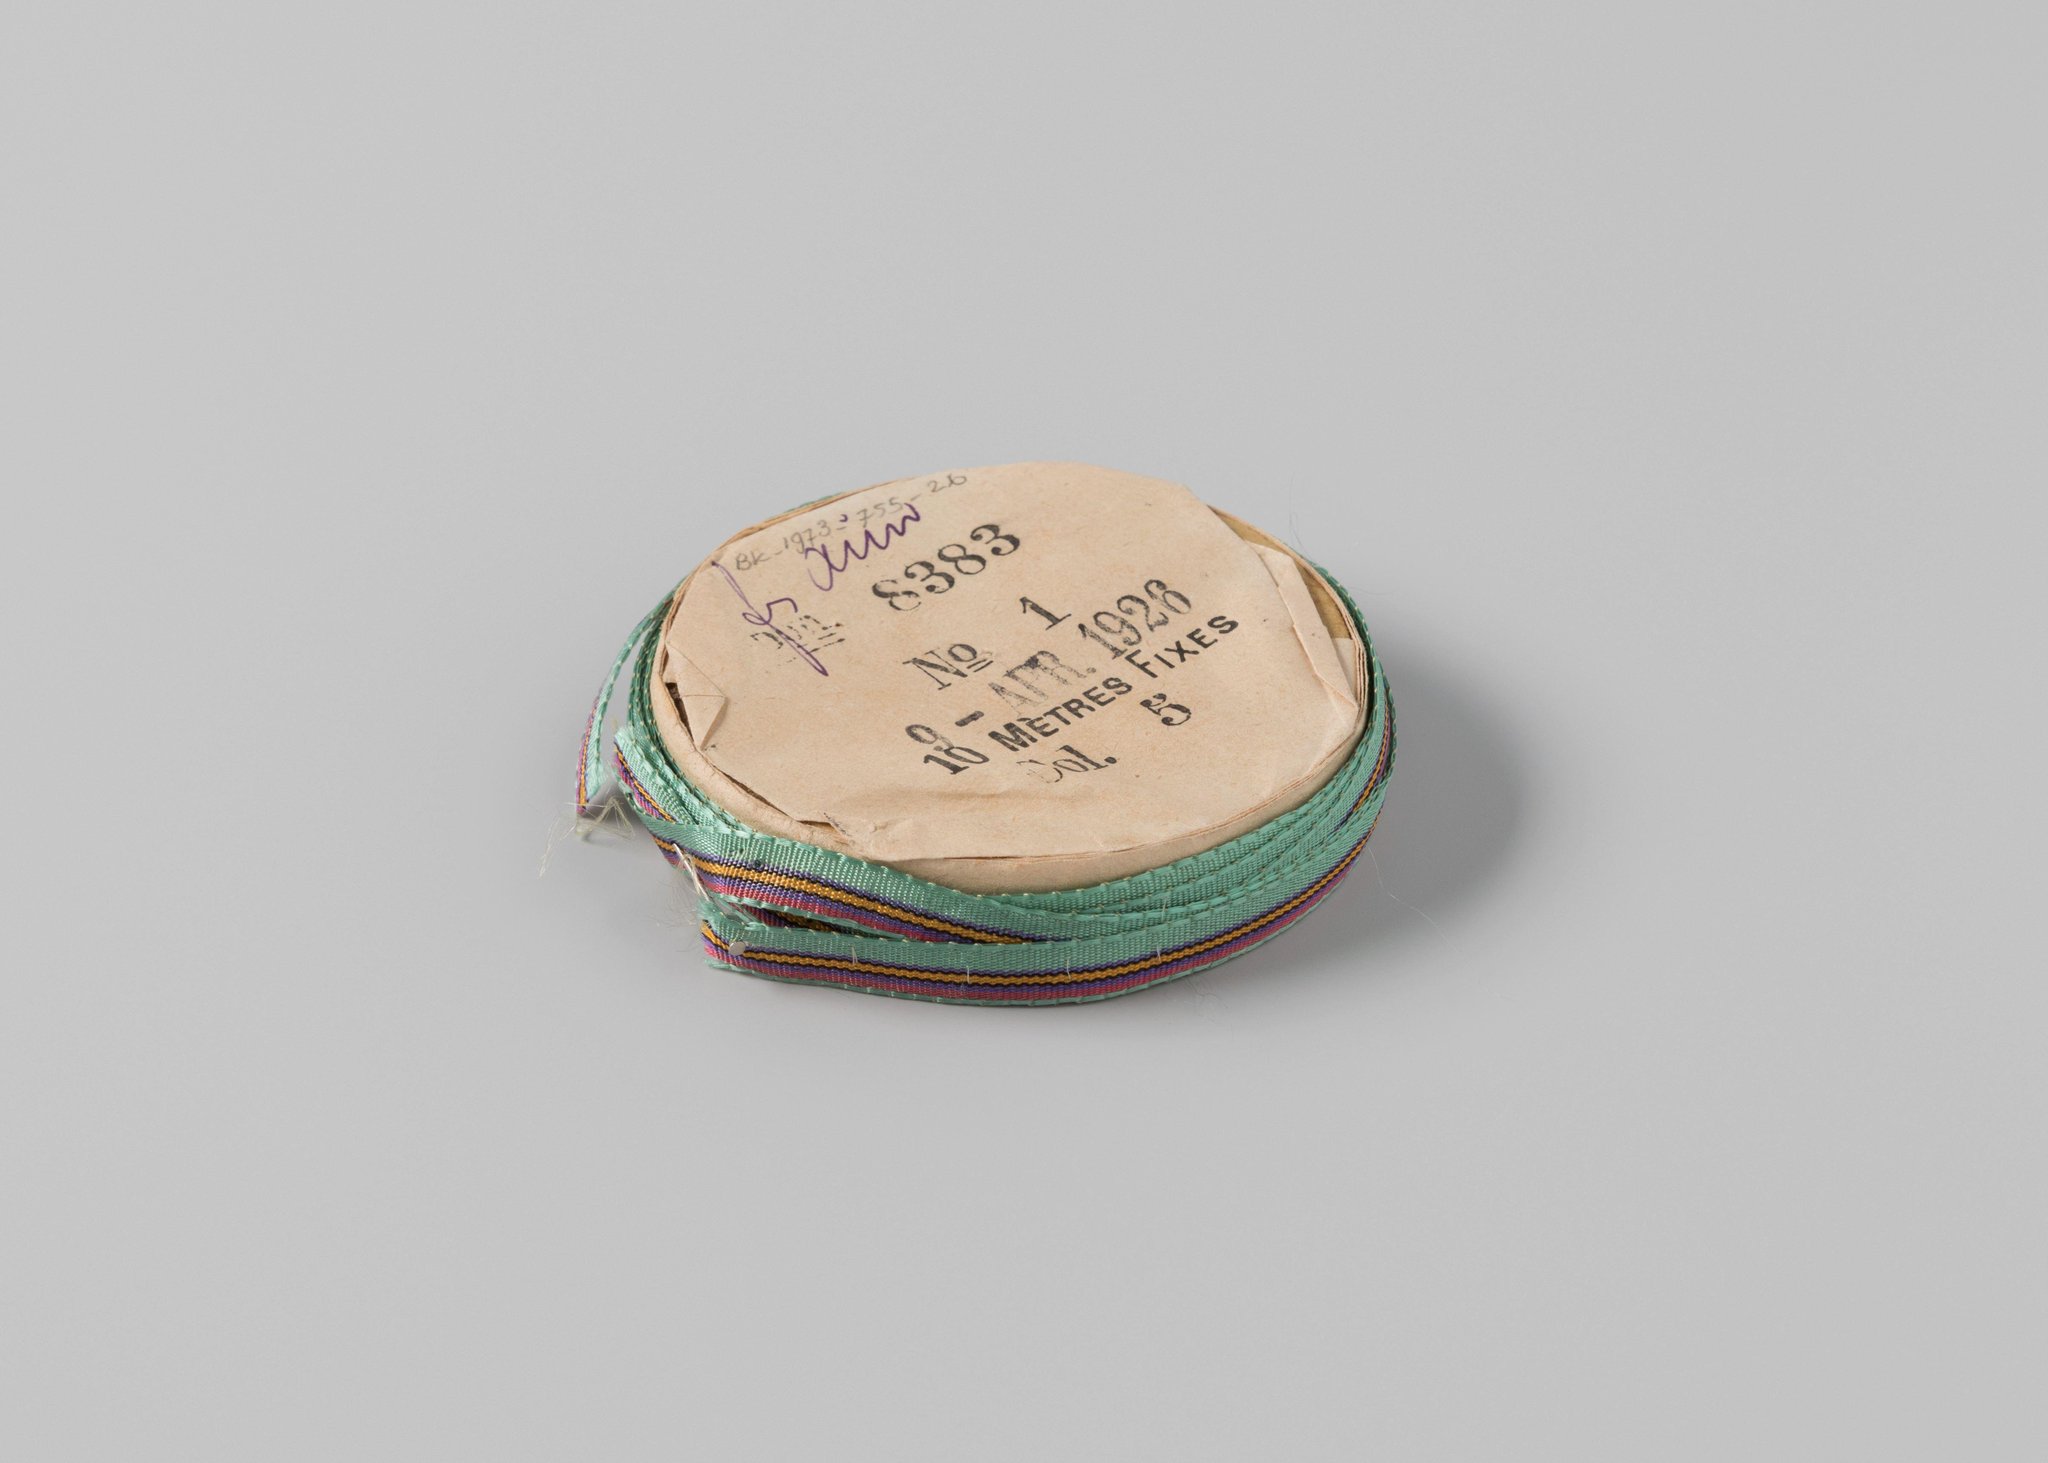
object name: ribbon material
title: Lint op rol, gestreept, groen met magenta, zwart, grijs en oranje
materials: cardboard, paper, textile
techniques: weave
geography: france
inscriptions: stamp: ‘9 - APR. 1926’, number: ‘Pon 8383’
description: Lint op rol, gestreept, groen met magenta, zwart, grijs en oranje.